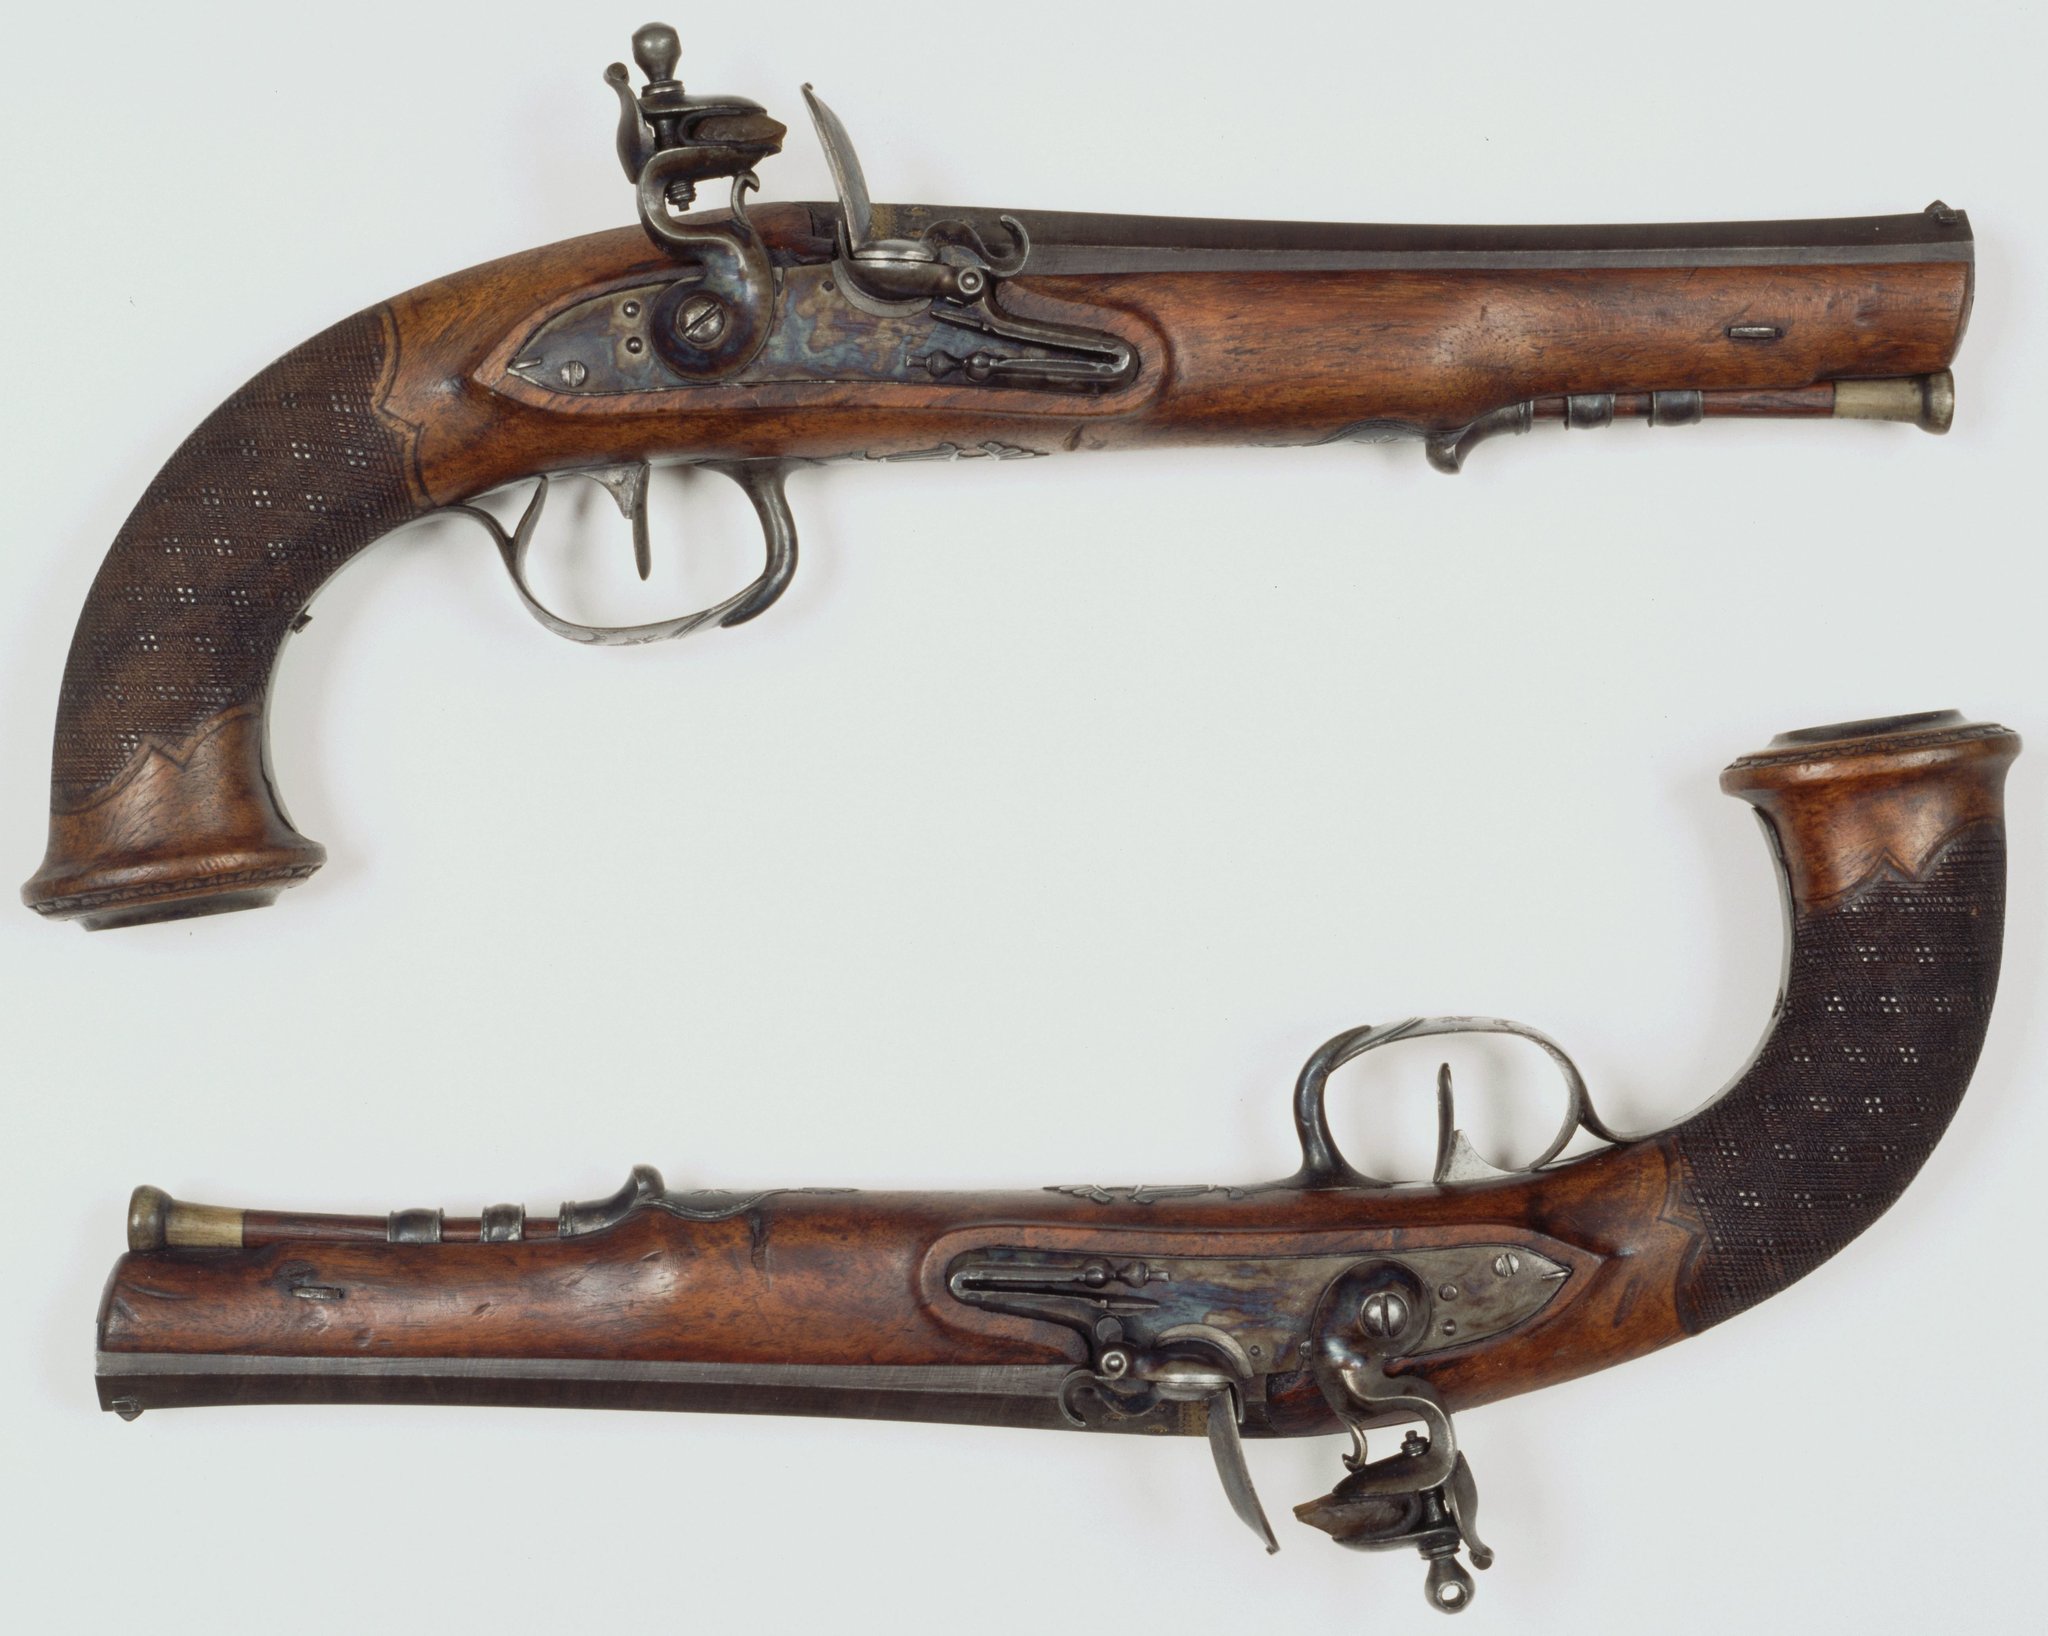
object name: flintlock pistol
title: Vuursteenpistool van jhr J.C.G. Fabricius van Leyenburg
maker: Anonymous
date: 1881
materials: iron, wood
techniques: burnishing, cutting, engraving, gilding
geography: western europe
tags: amsterdam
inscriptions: mark: ‘EX’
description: Vuursteenpistool, deel van koppel. Achtkantige gebruineerde getrokken loop en met een sneller. Op de drie vlakken van de loop een figuur bestaande uit drie vergulde lelies (?) geplaatst 1,2 op het bovenvlak. Tussen de lelies staat: EX en een verguld lopend dier, een hond of schaap, van rechts naar links gekeerd. Het ijzerwerk is geblauwd. IJzeren vizierkorrel. Ronde gebruineerde slotplaat. Twee gegraveerde zijplaten. Greep van de lade met snijwerk. Afkomstig van de 1e luitenant der Amsterdamse schutterij te paard Jhr. J.C.G. Fabricius van Leyenburg.